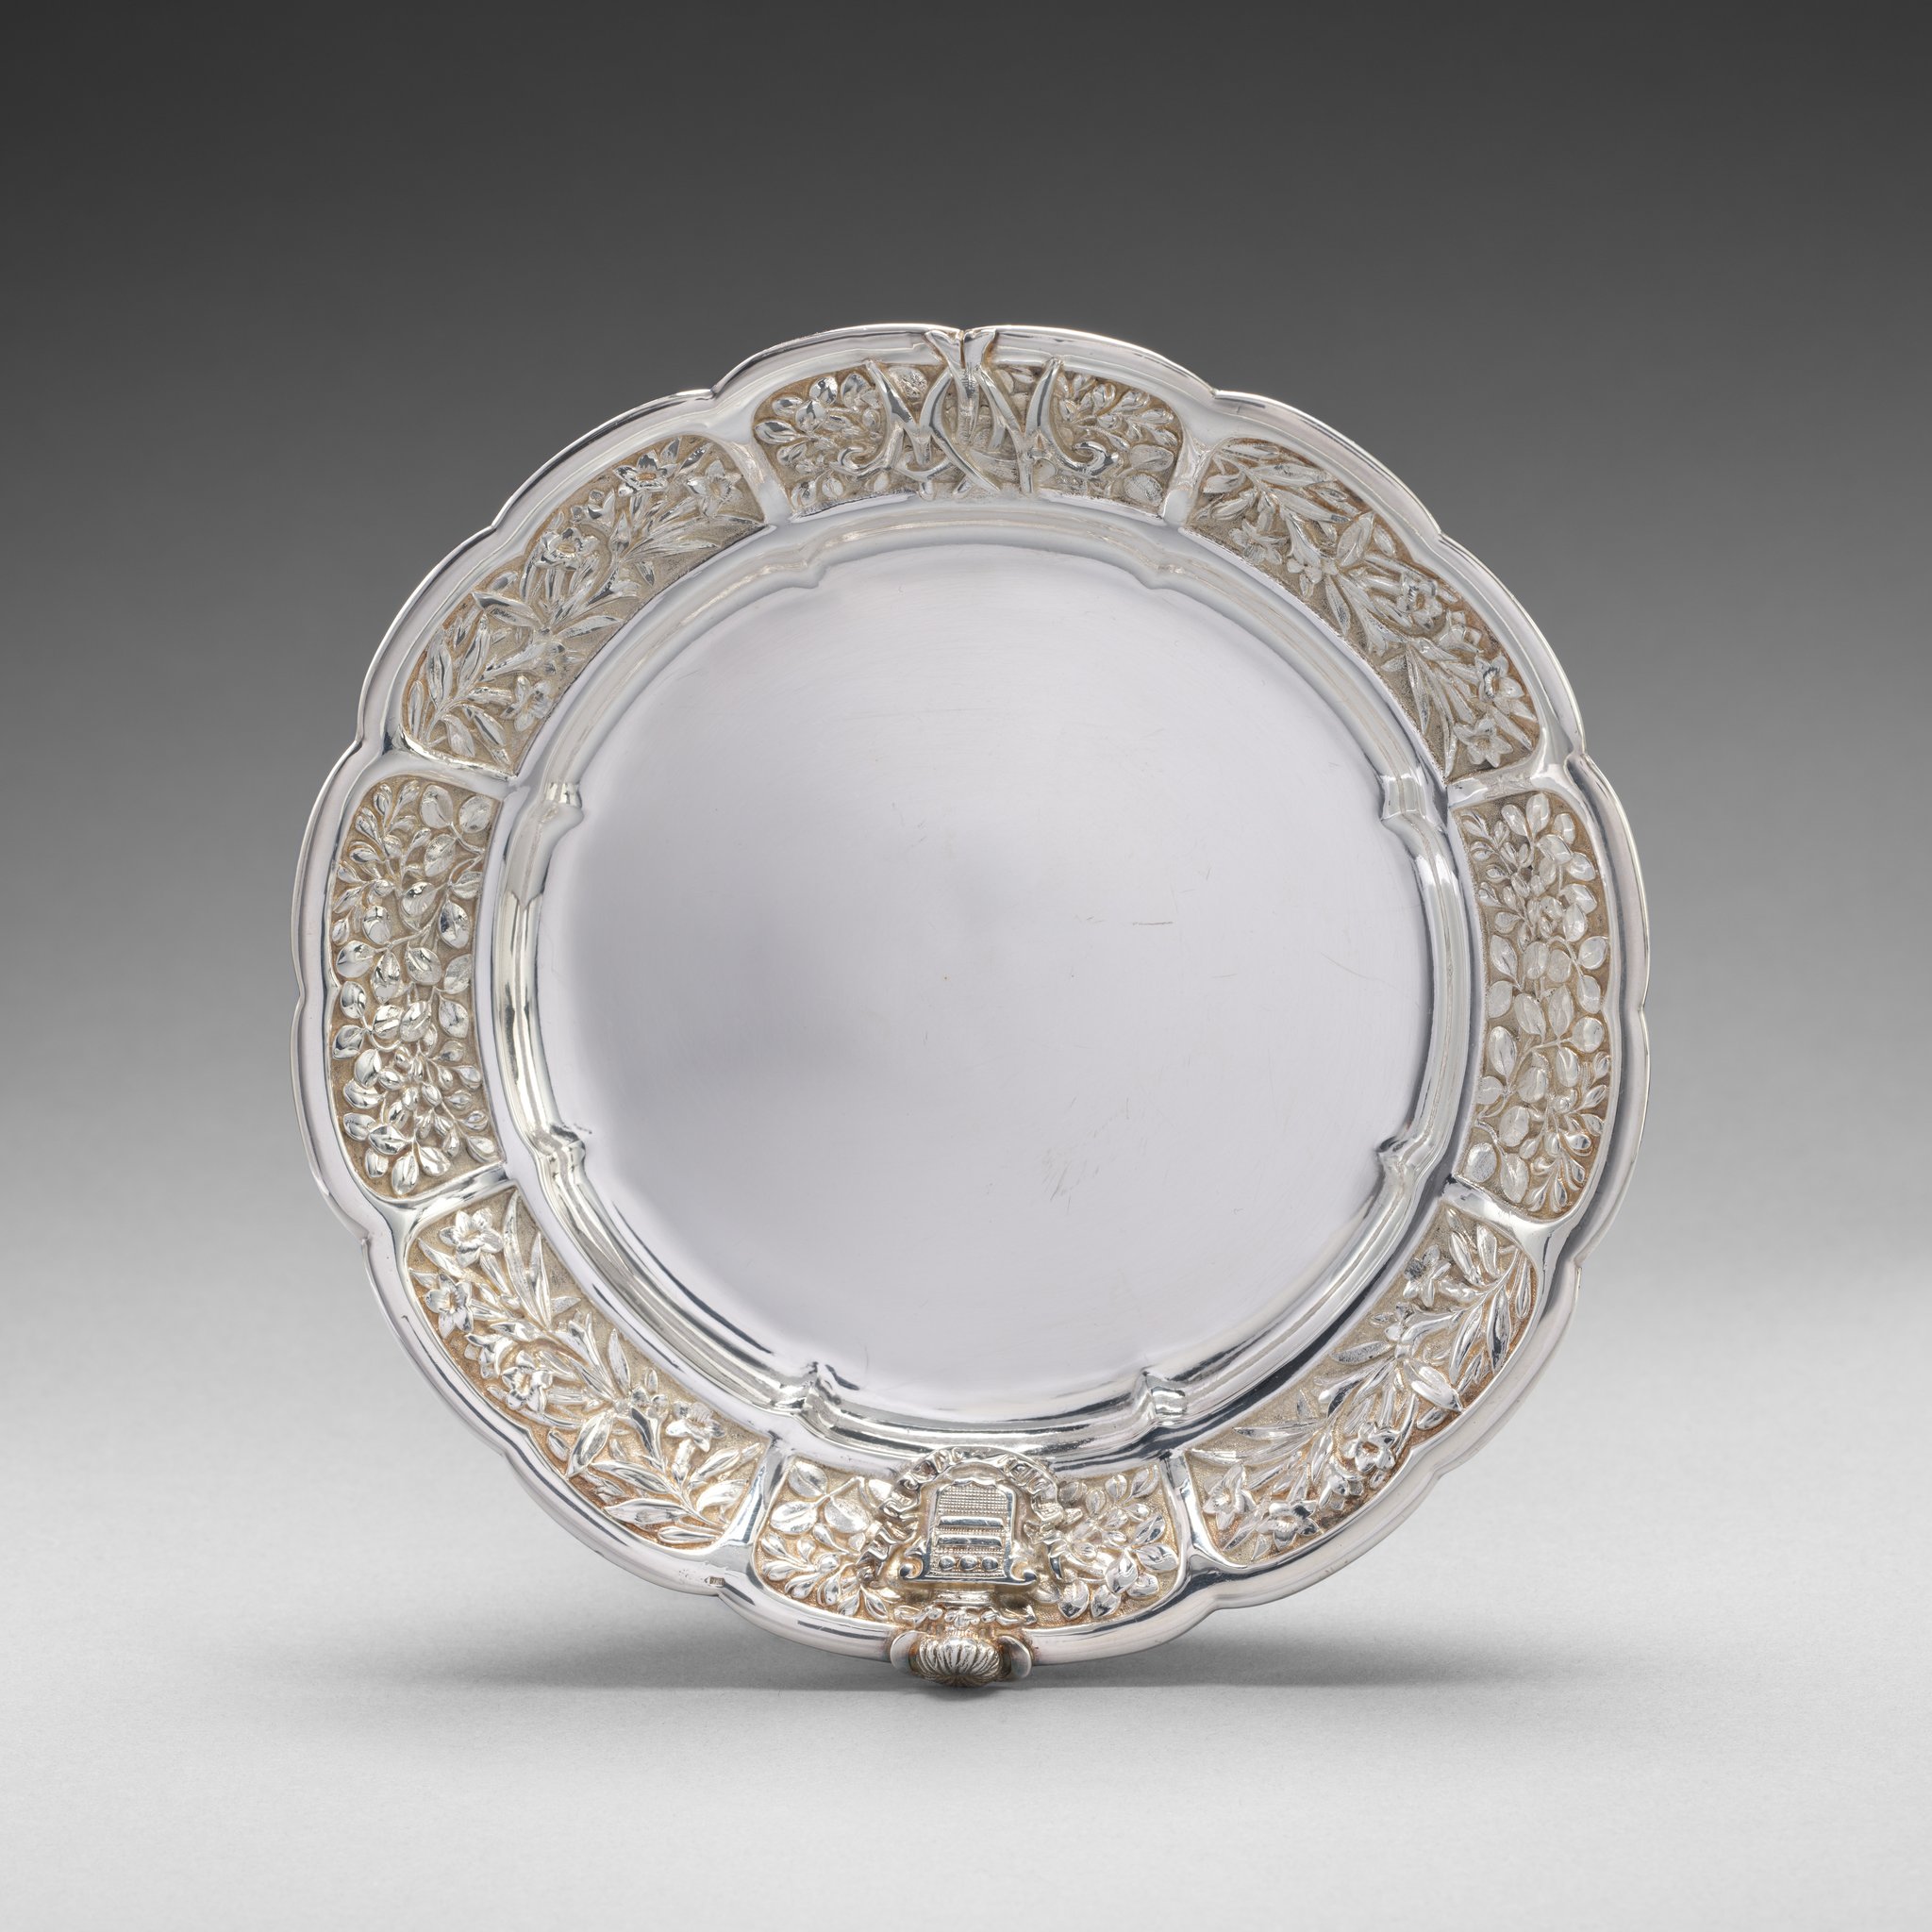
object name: ice cream plate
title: Ice Cream Plate from Mackay Service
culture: american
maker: tiffany & co.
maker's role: maker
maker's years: 1837-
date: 1878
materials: silver